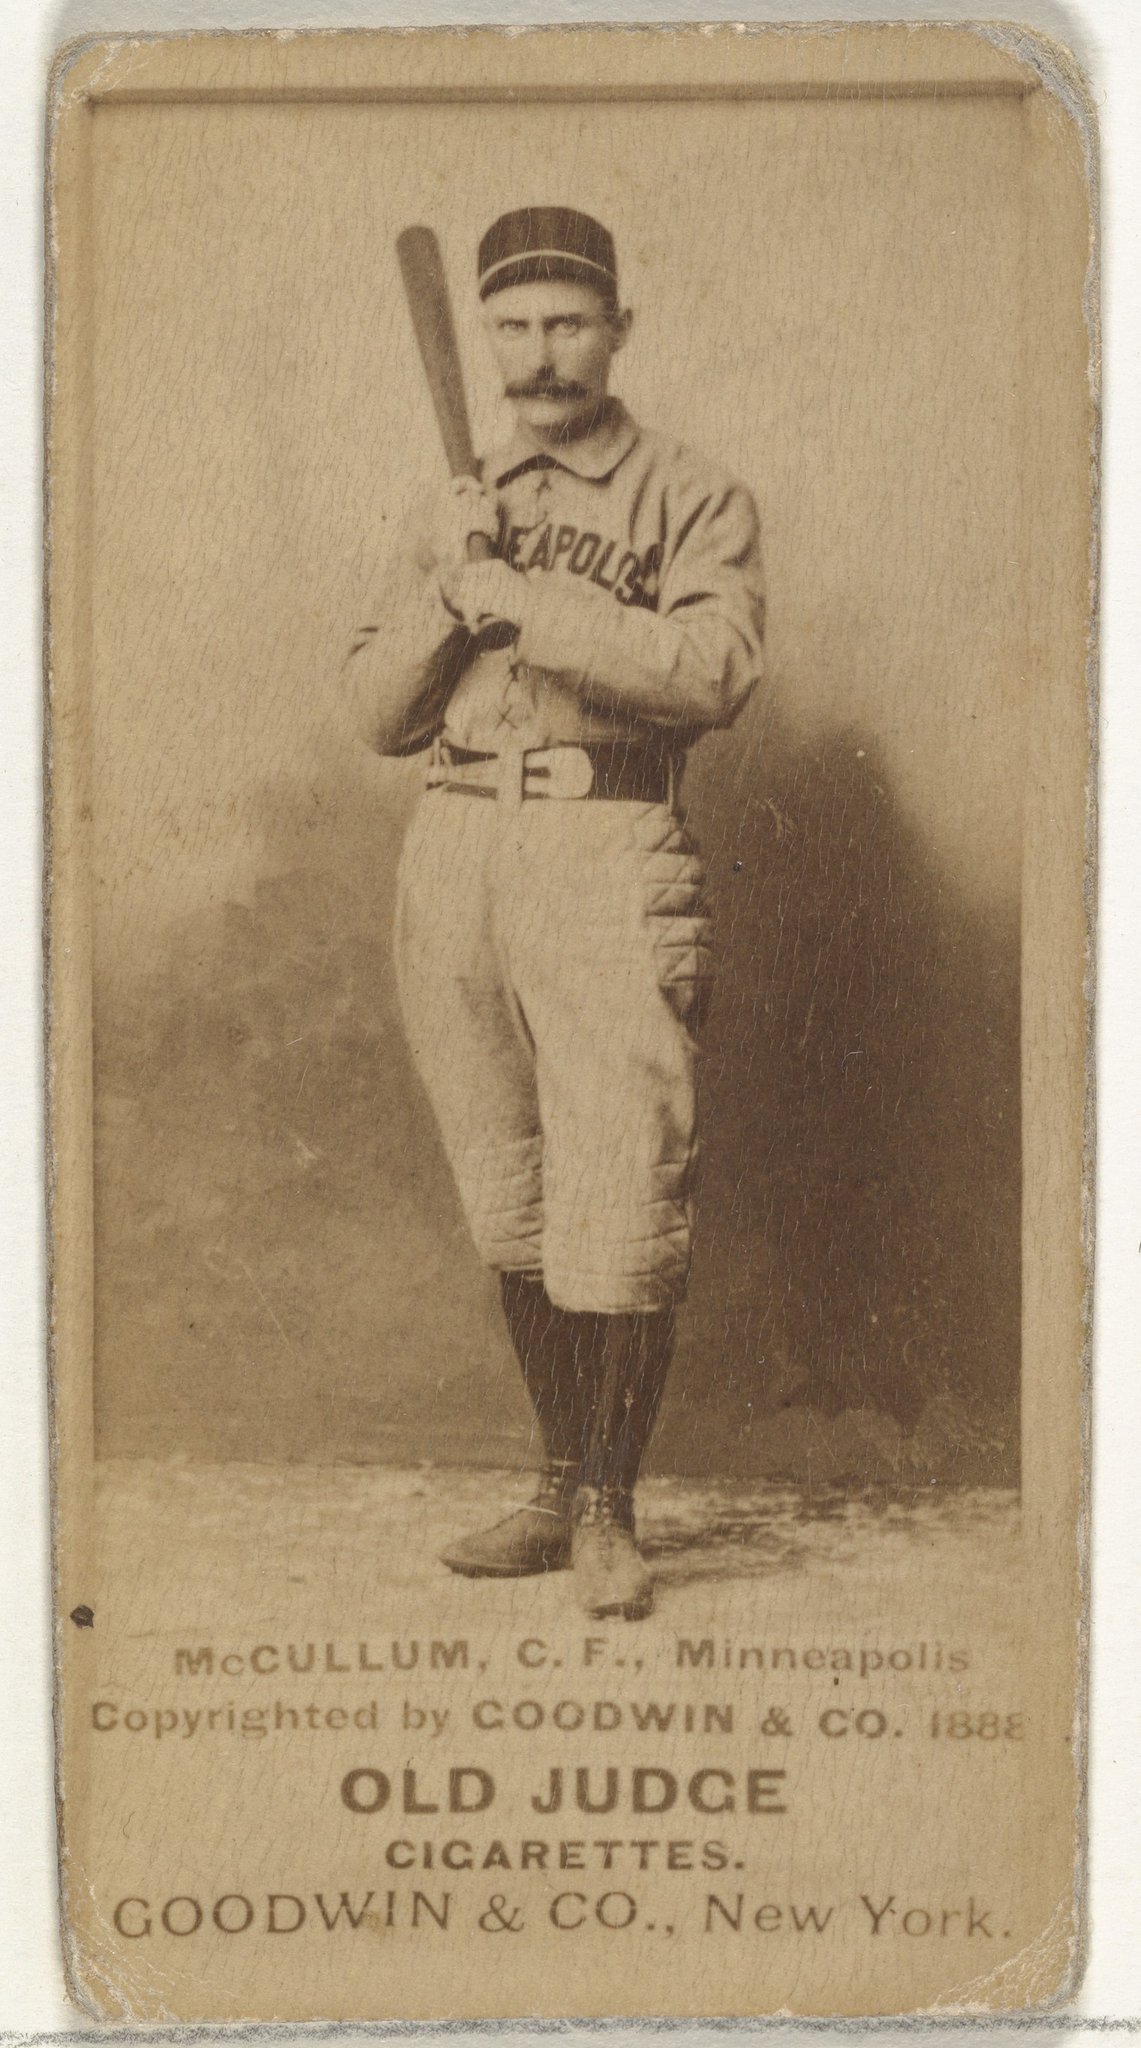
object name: baseball card, photograph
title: Thomas McCallum, Center Field, Minneapolis, from the Old Judge series (N172) for Old Judge Cigarettes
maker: goodwin & company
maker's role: publisher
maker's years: 1850-1950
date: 1888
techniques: albumen silver print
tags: men,portraits,baseball,athletes